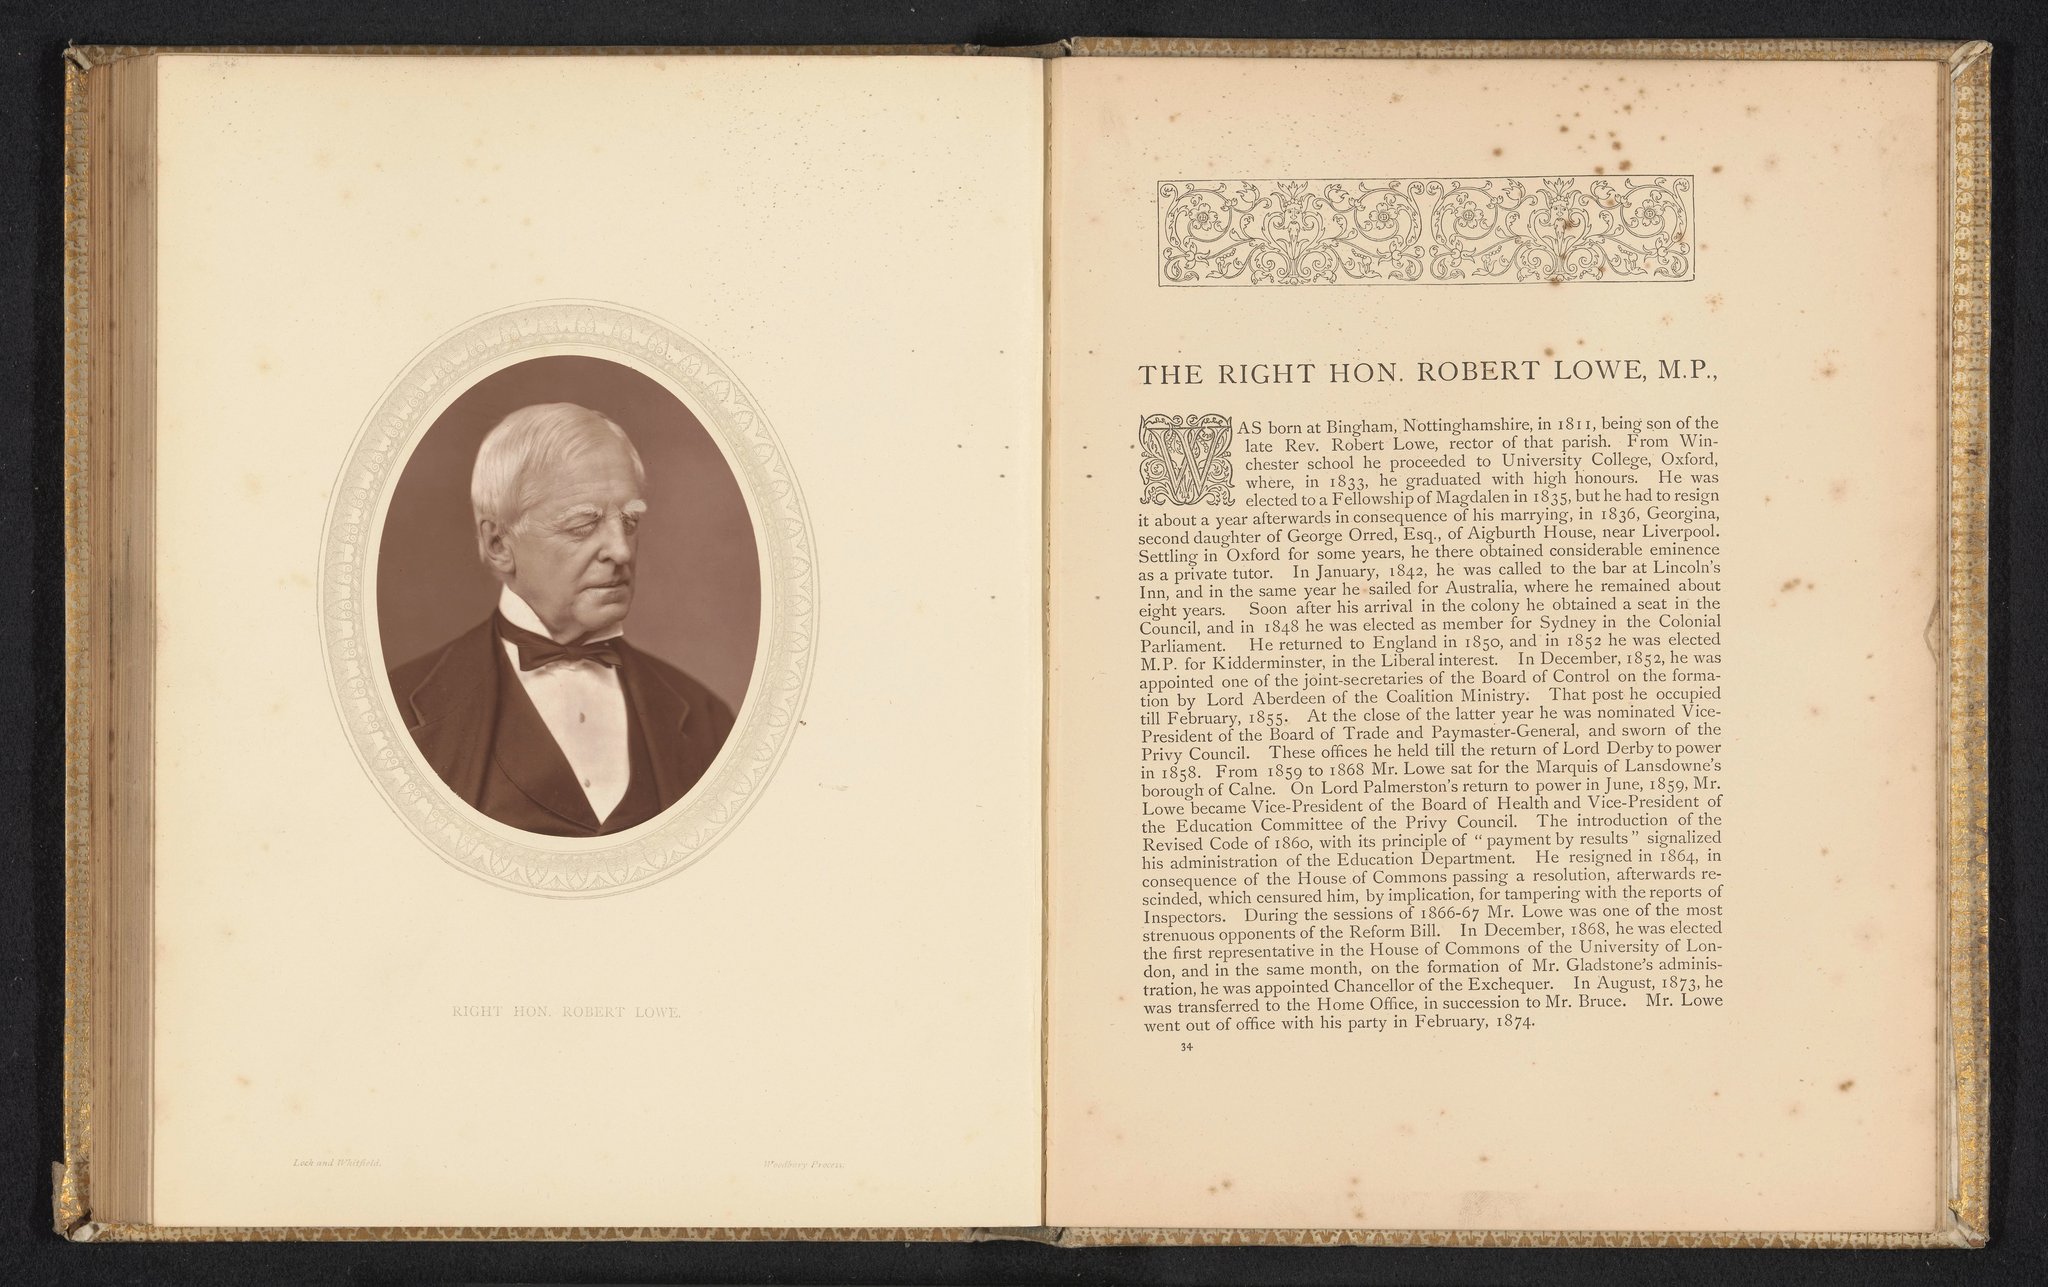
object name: photomechanical print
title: Right hon. Robert Lowe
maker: Anonymous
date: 1873-1878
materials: paper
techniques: woodburytype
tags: historical persons (portraits and scenes from the life) (+ (full) bust portrait), politician, e.g. party leader